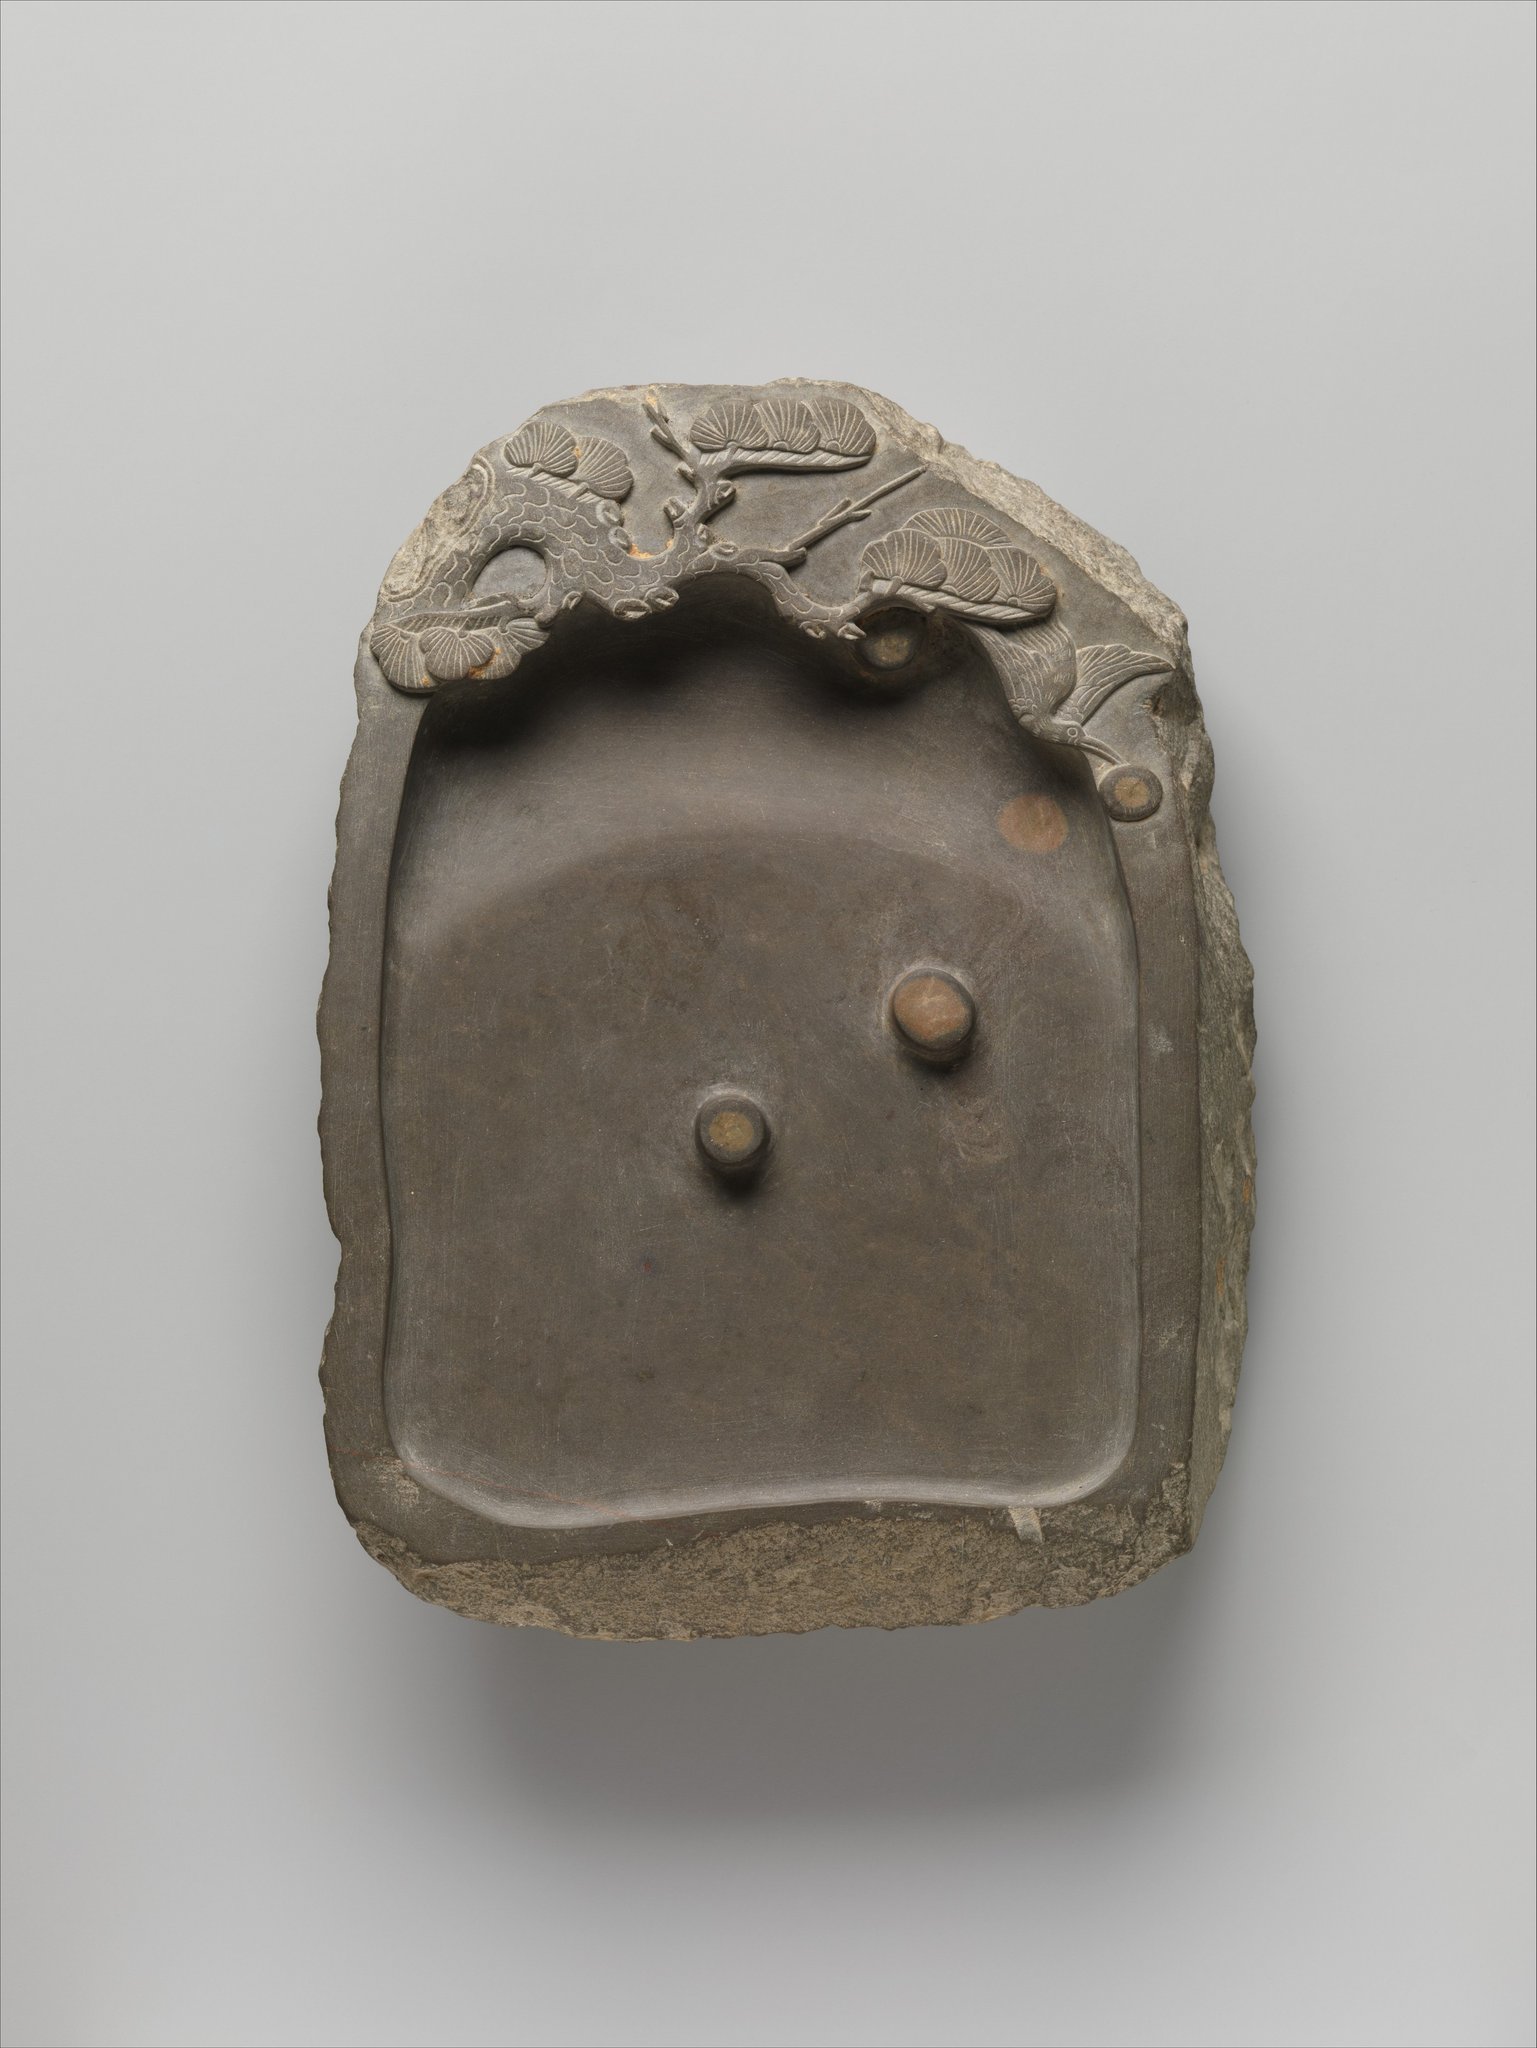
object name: inkstone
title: Inkstone with Pine Tree and Bird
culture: chinese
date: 1501-1600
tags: birds,trees